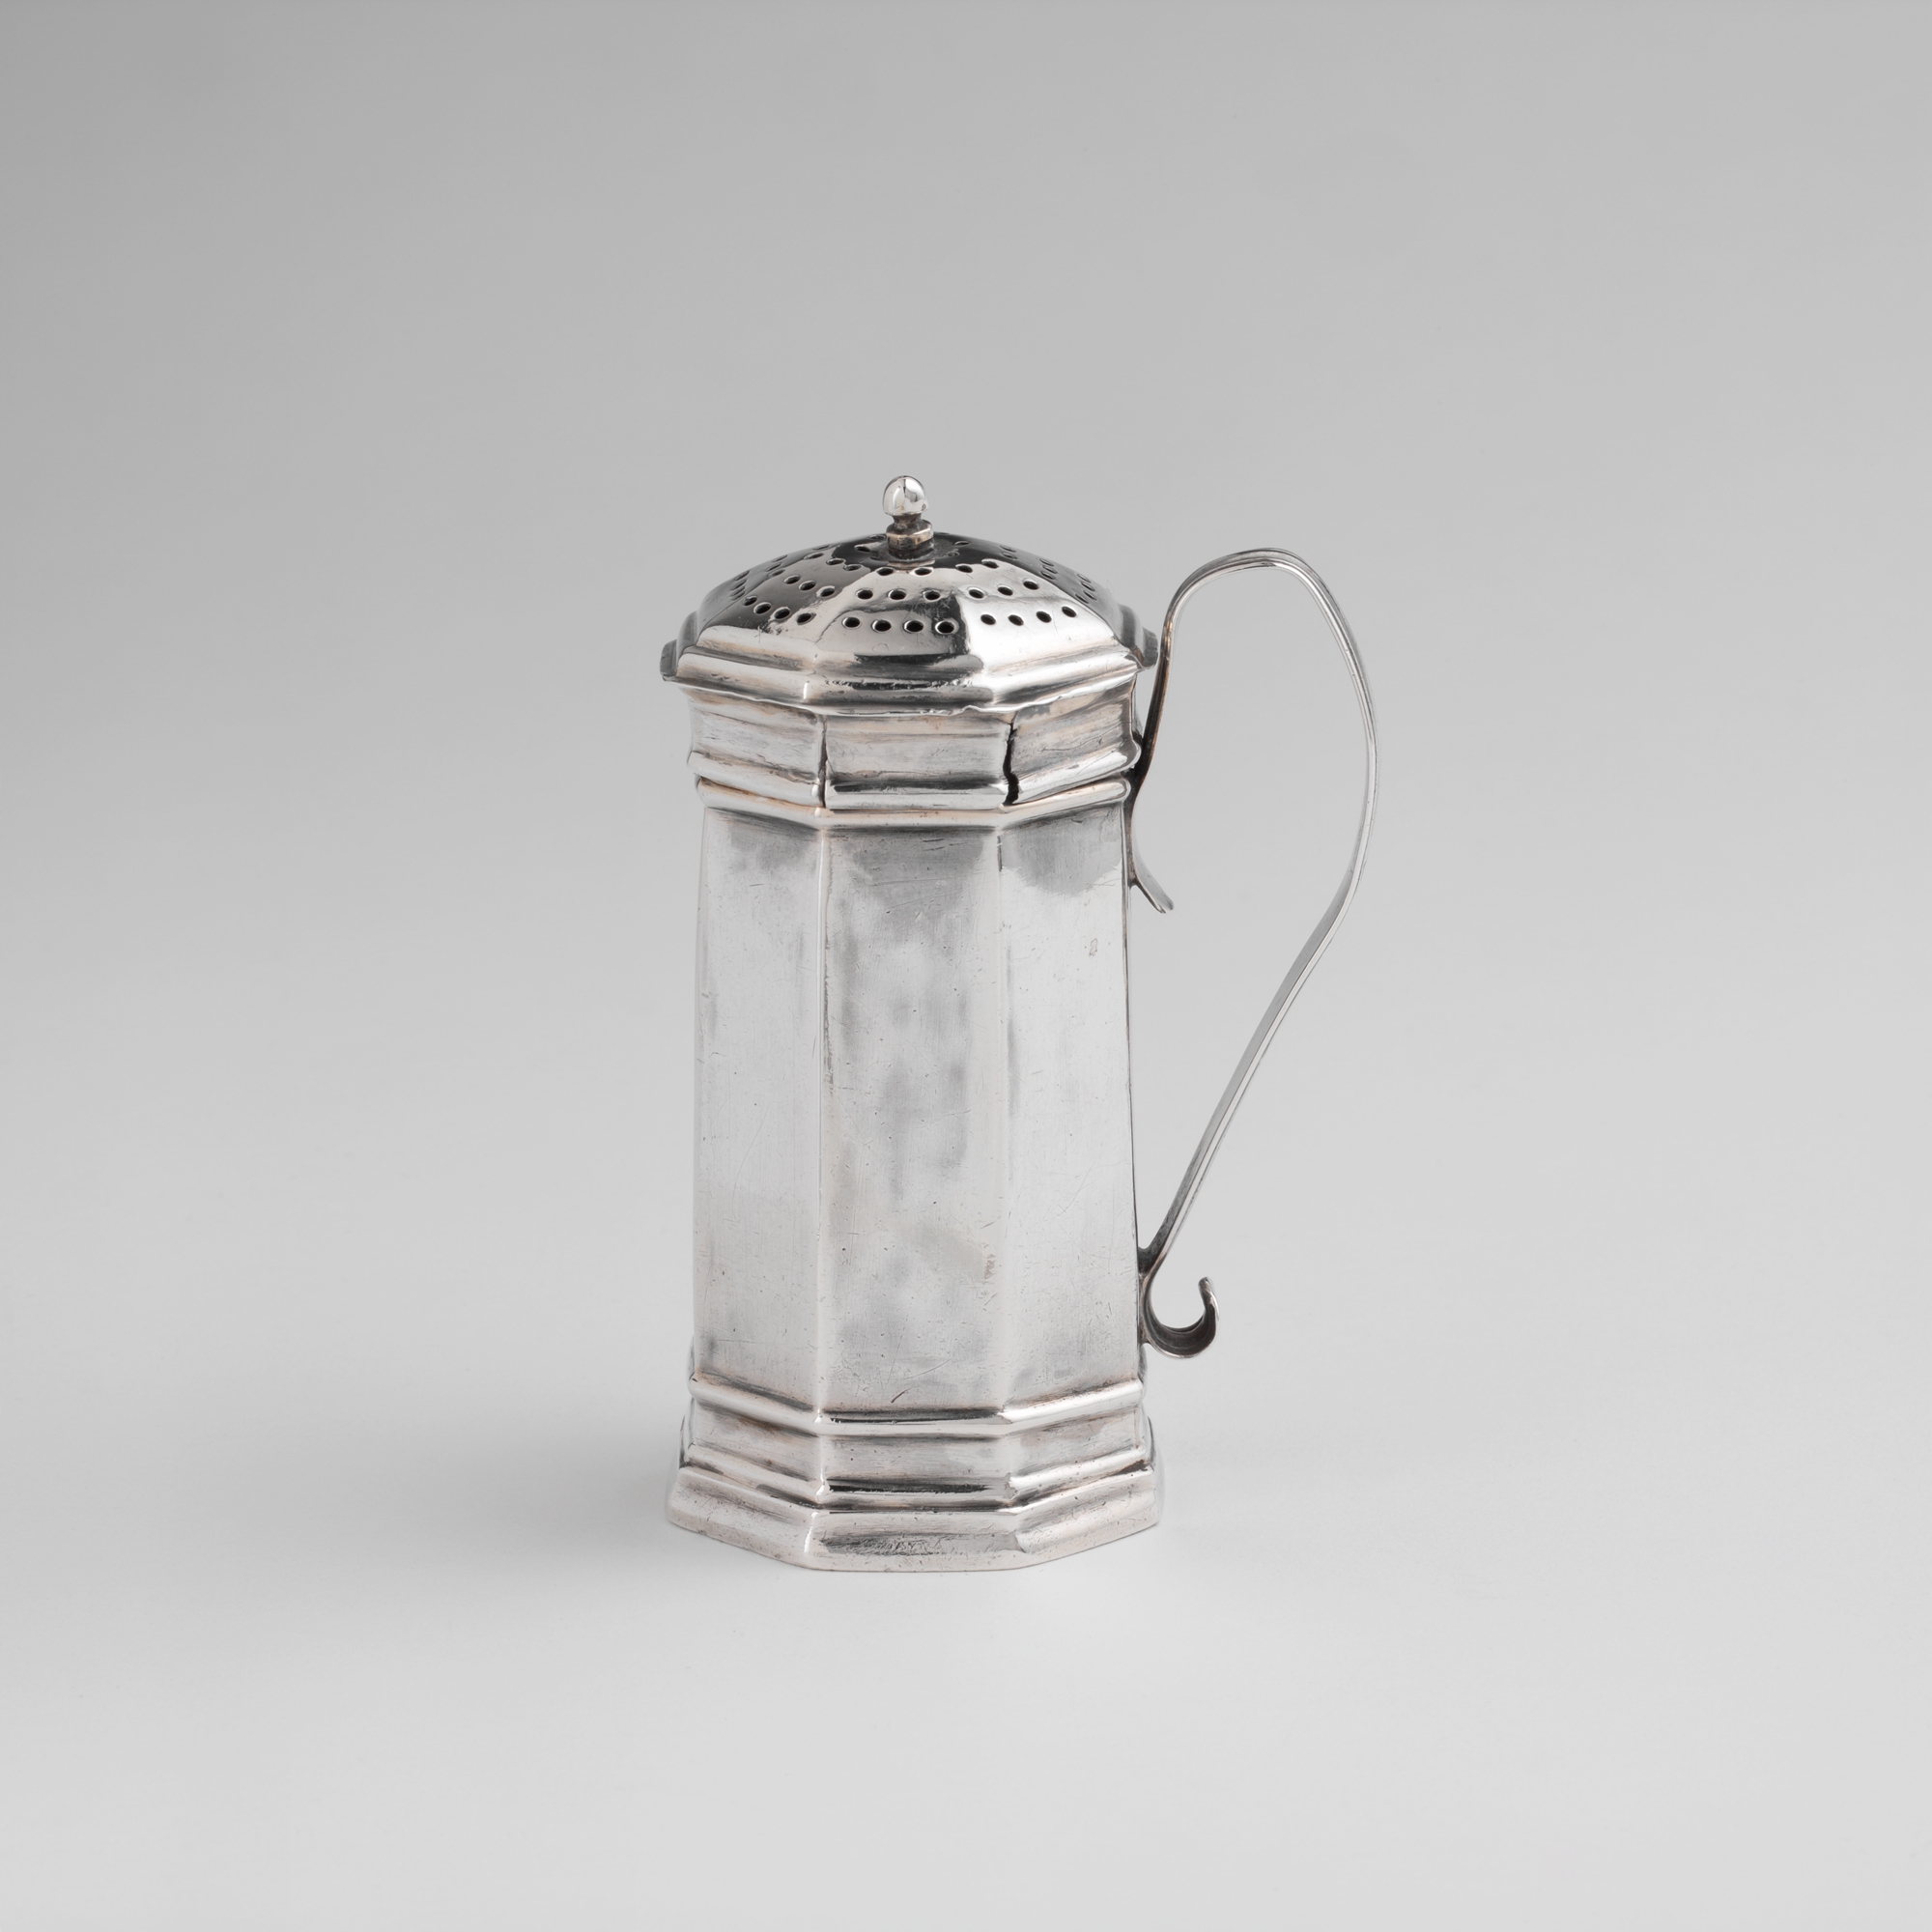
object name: caster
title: Pepper Box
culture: american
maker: moody russell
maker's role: maker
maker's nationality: american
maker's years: 1694-1761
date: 1720-1735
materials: silver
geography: united states